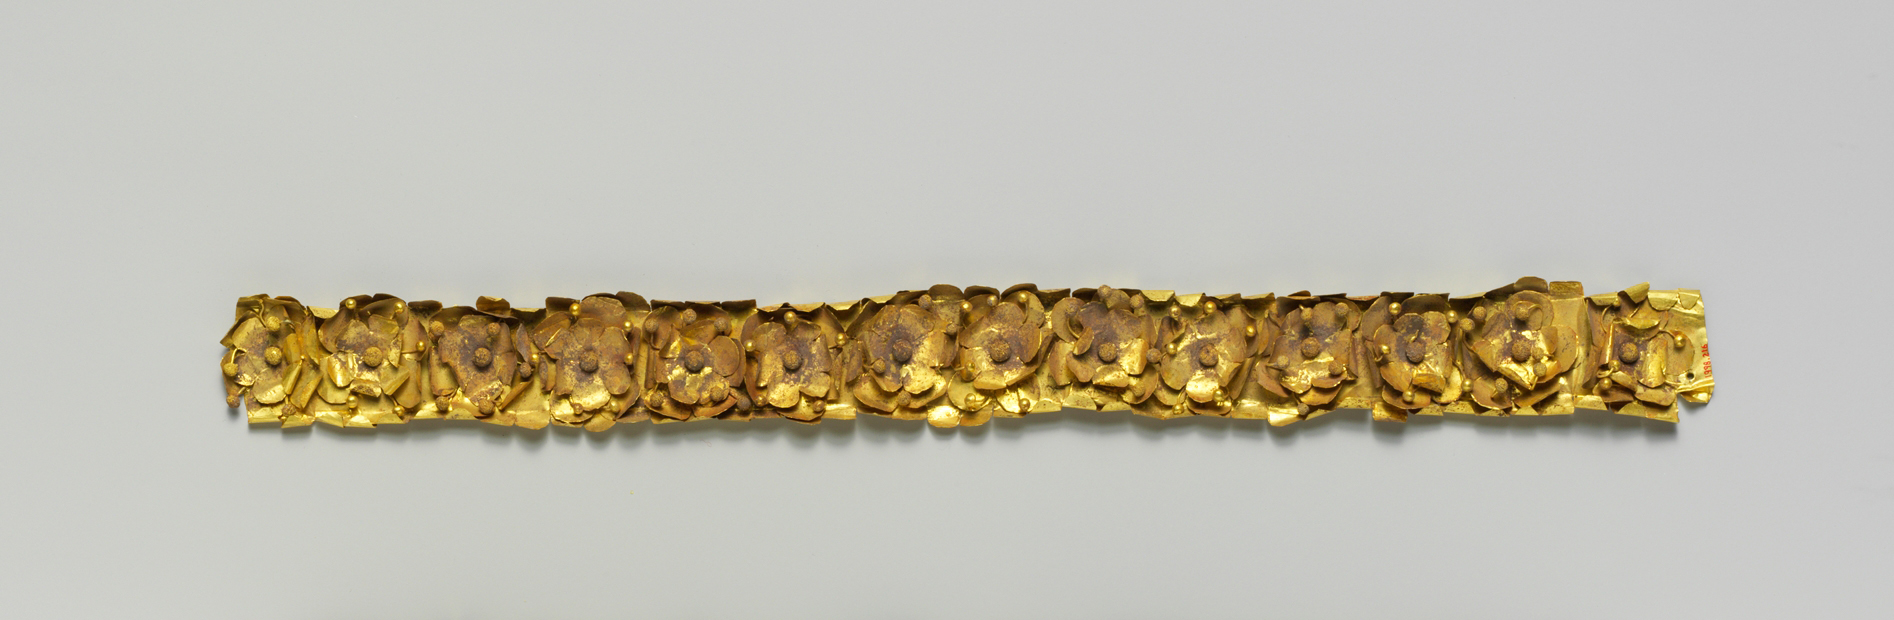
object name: diadem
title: Gold diadem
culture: greek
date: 300-201 BCE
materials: gold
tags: diadems